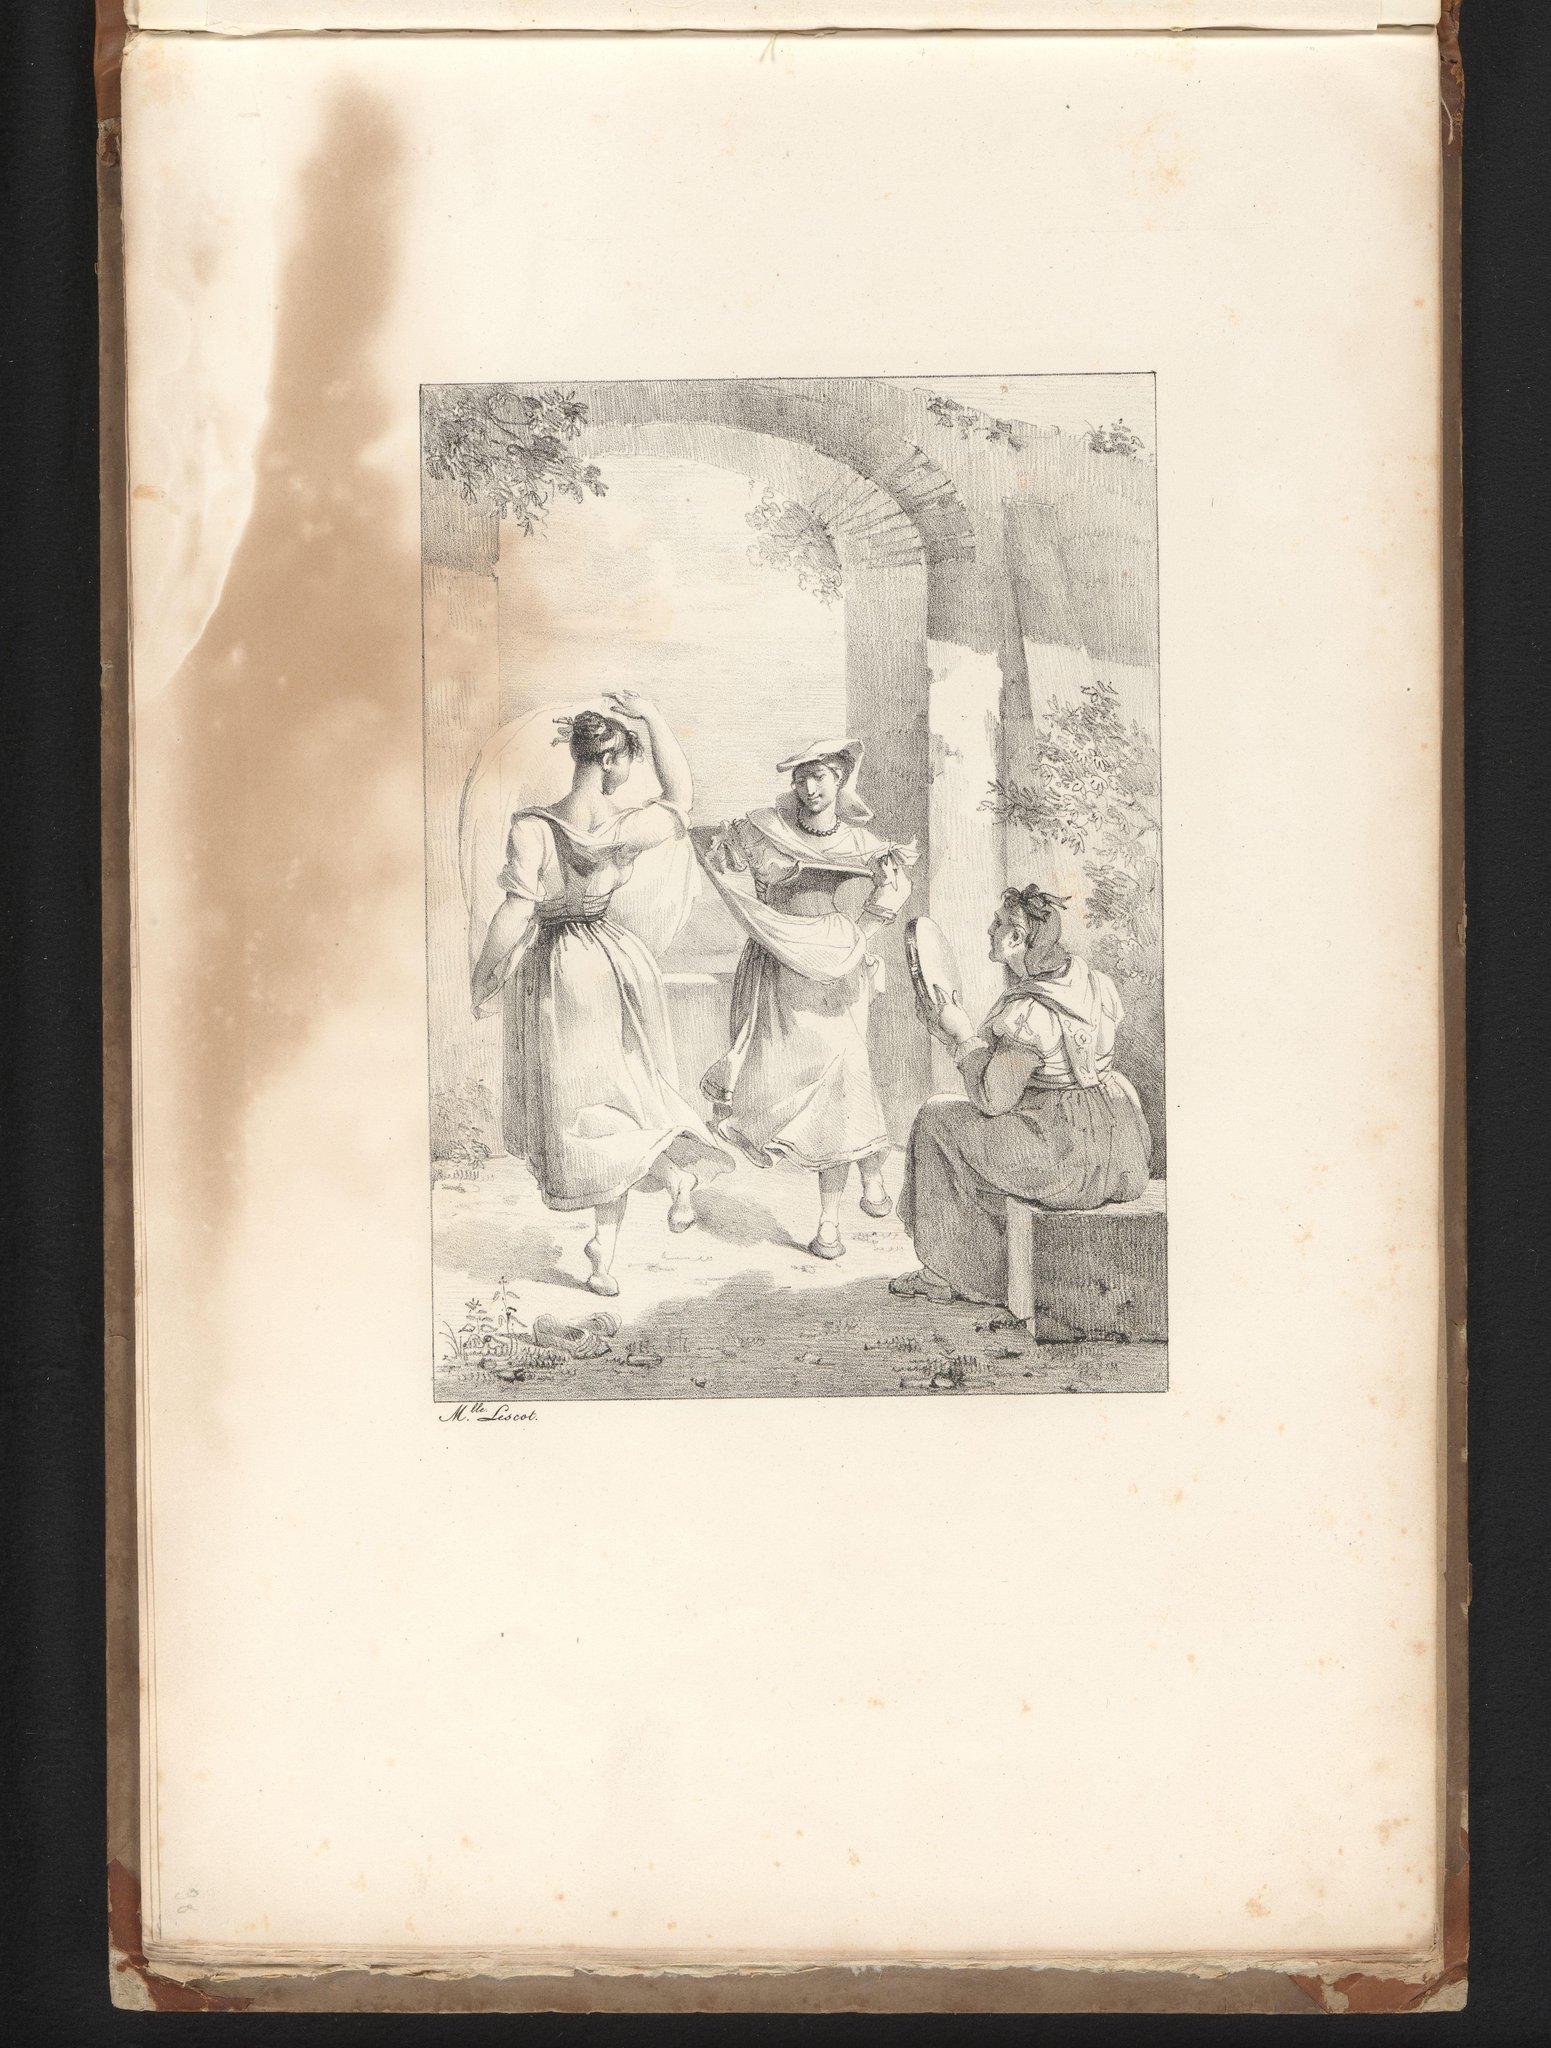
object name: print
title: Receuil de dessins sur pierre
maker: antoinette cécile hortense haudebourt-lescot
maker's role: painter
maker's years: 1784-1845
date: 1818-1819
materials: paper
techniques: lithograph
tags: dancing